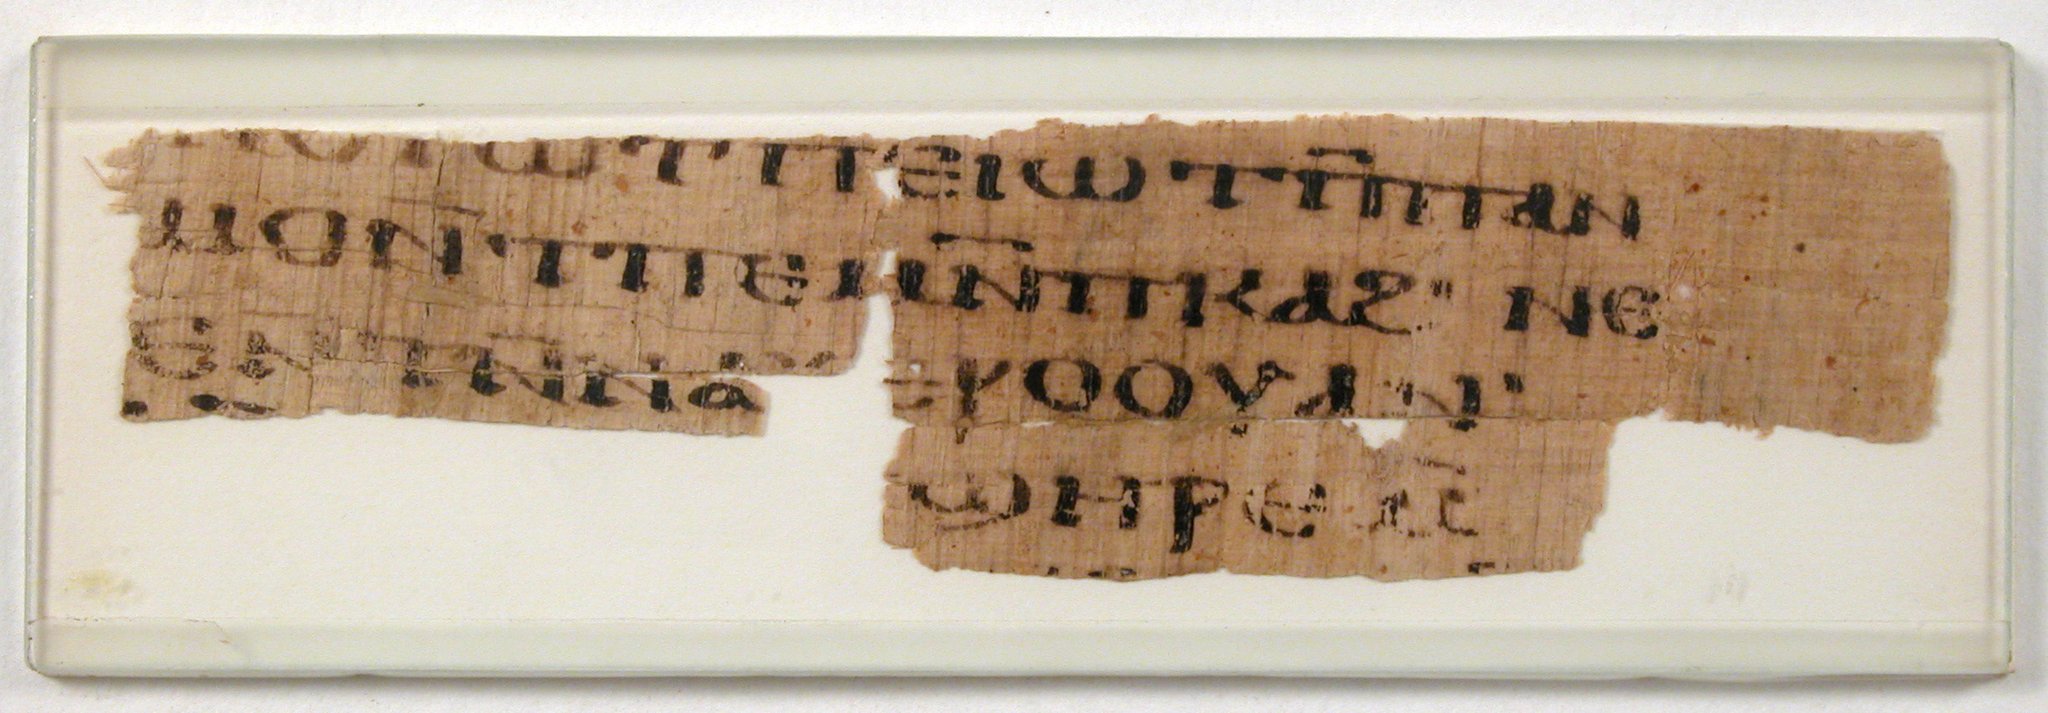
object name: papyrus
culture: coptic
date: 600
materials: ink, papyrus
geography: egypt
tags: coptic